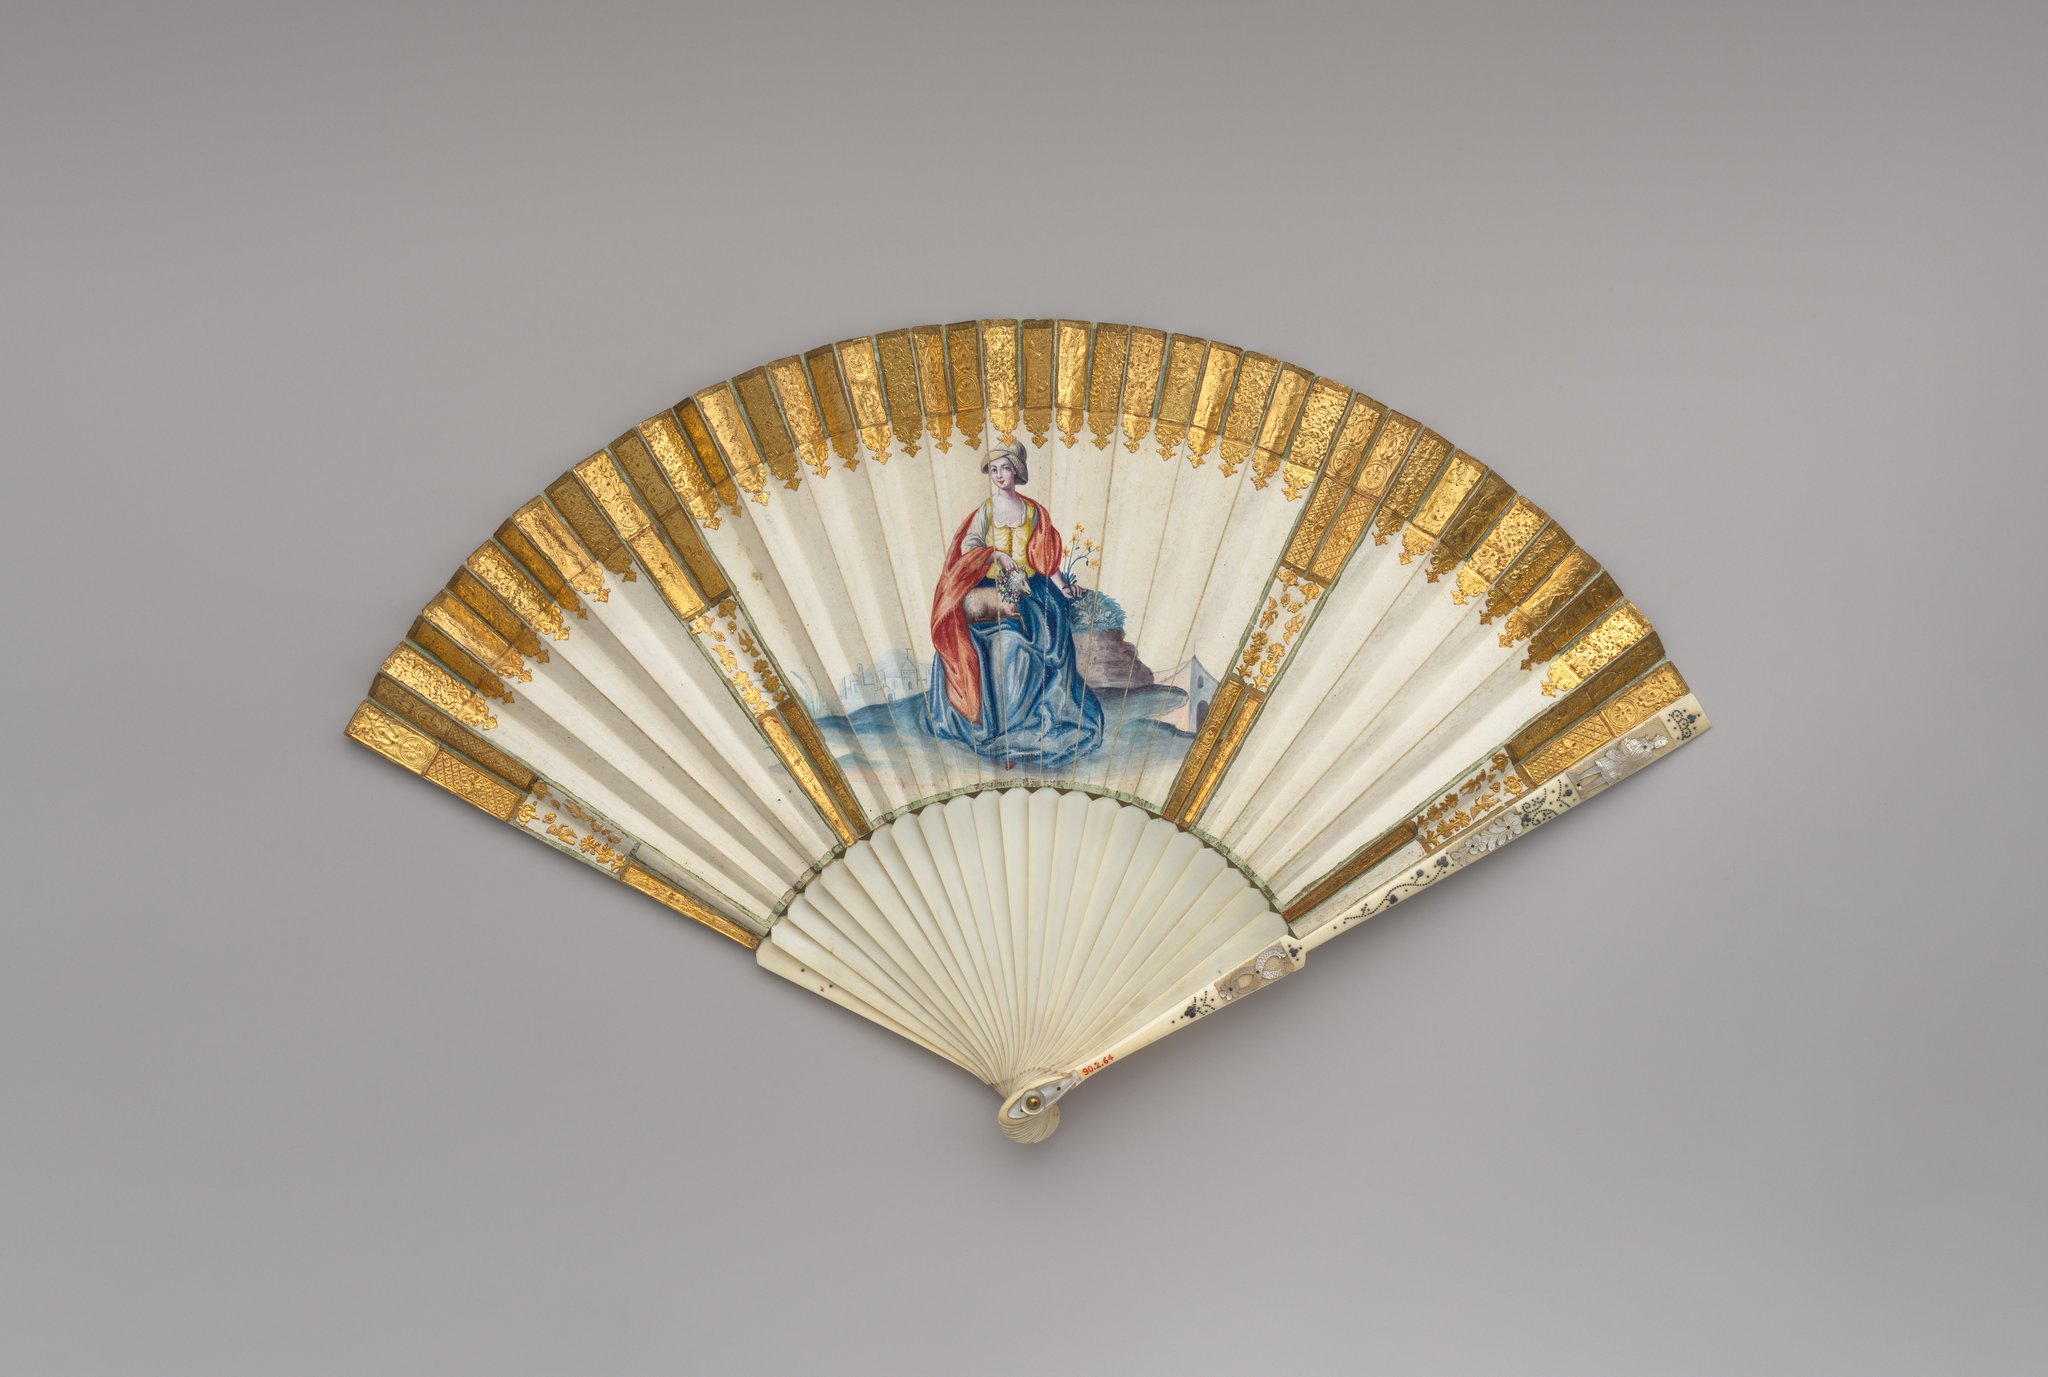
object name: fan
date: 1801-1900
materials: gold, ivory, mother of pearl, paper, silver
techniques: inlay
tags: animals,women